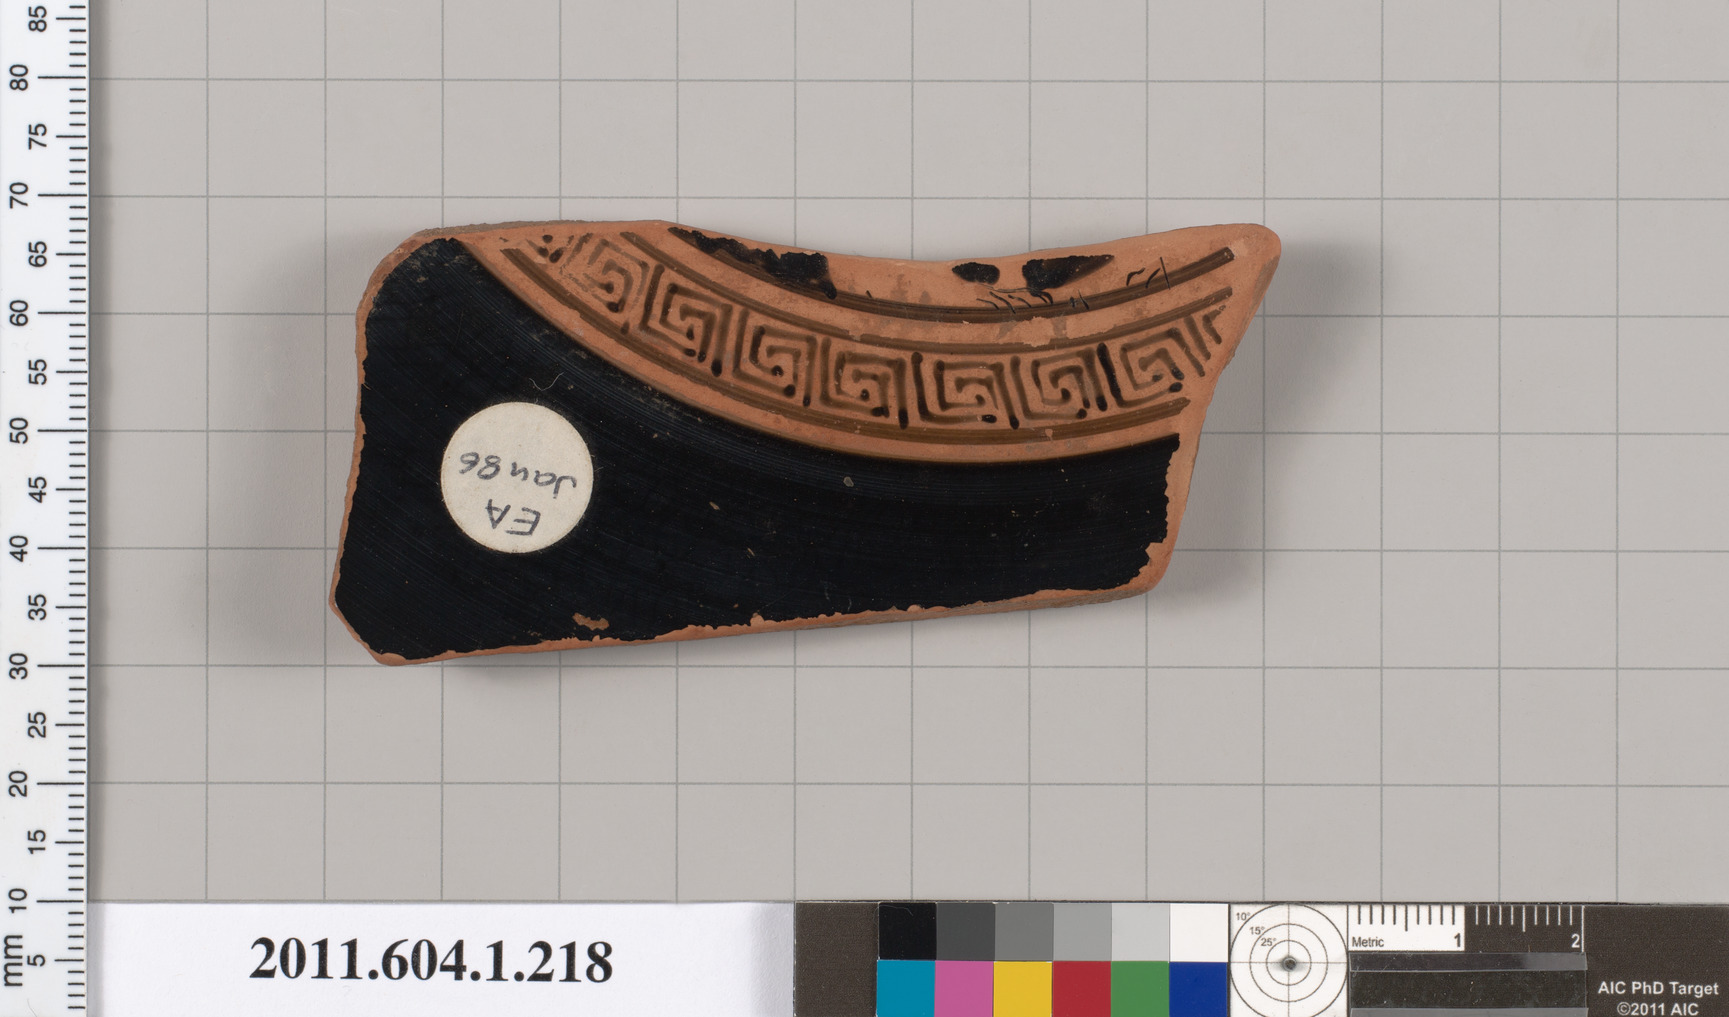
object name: kylix fragment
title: Terracotta fragment of a kylix (drinking cup)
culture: greek, attic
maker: painter of brussels r 330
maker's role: artist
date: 475-451 BCE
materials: terracotta